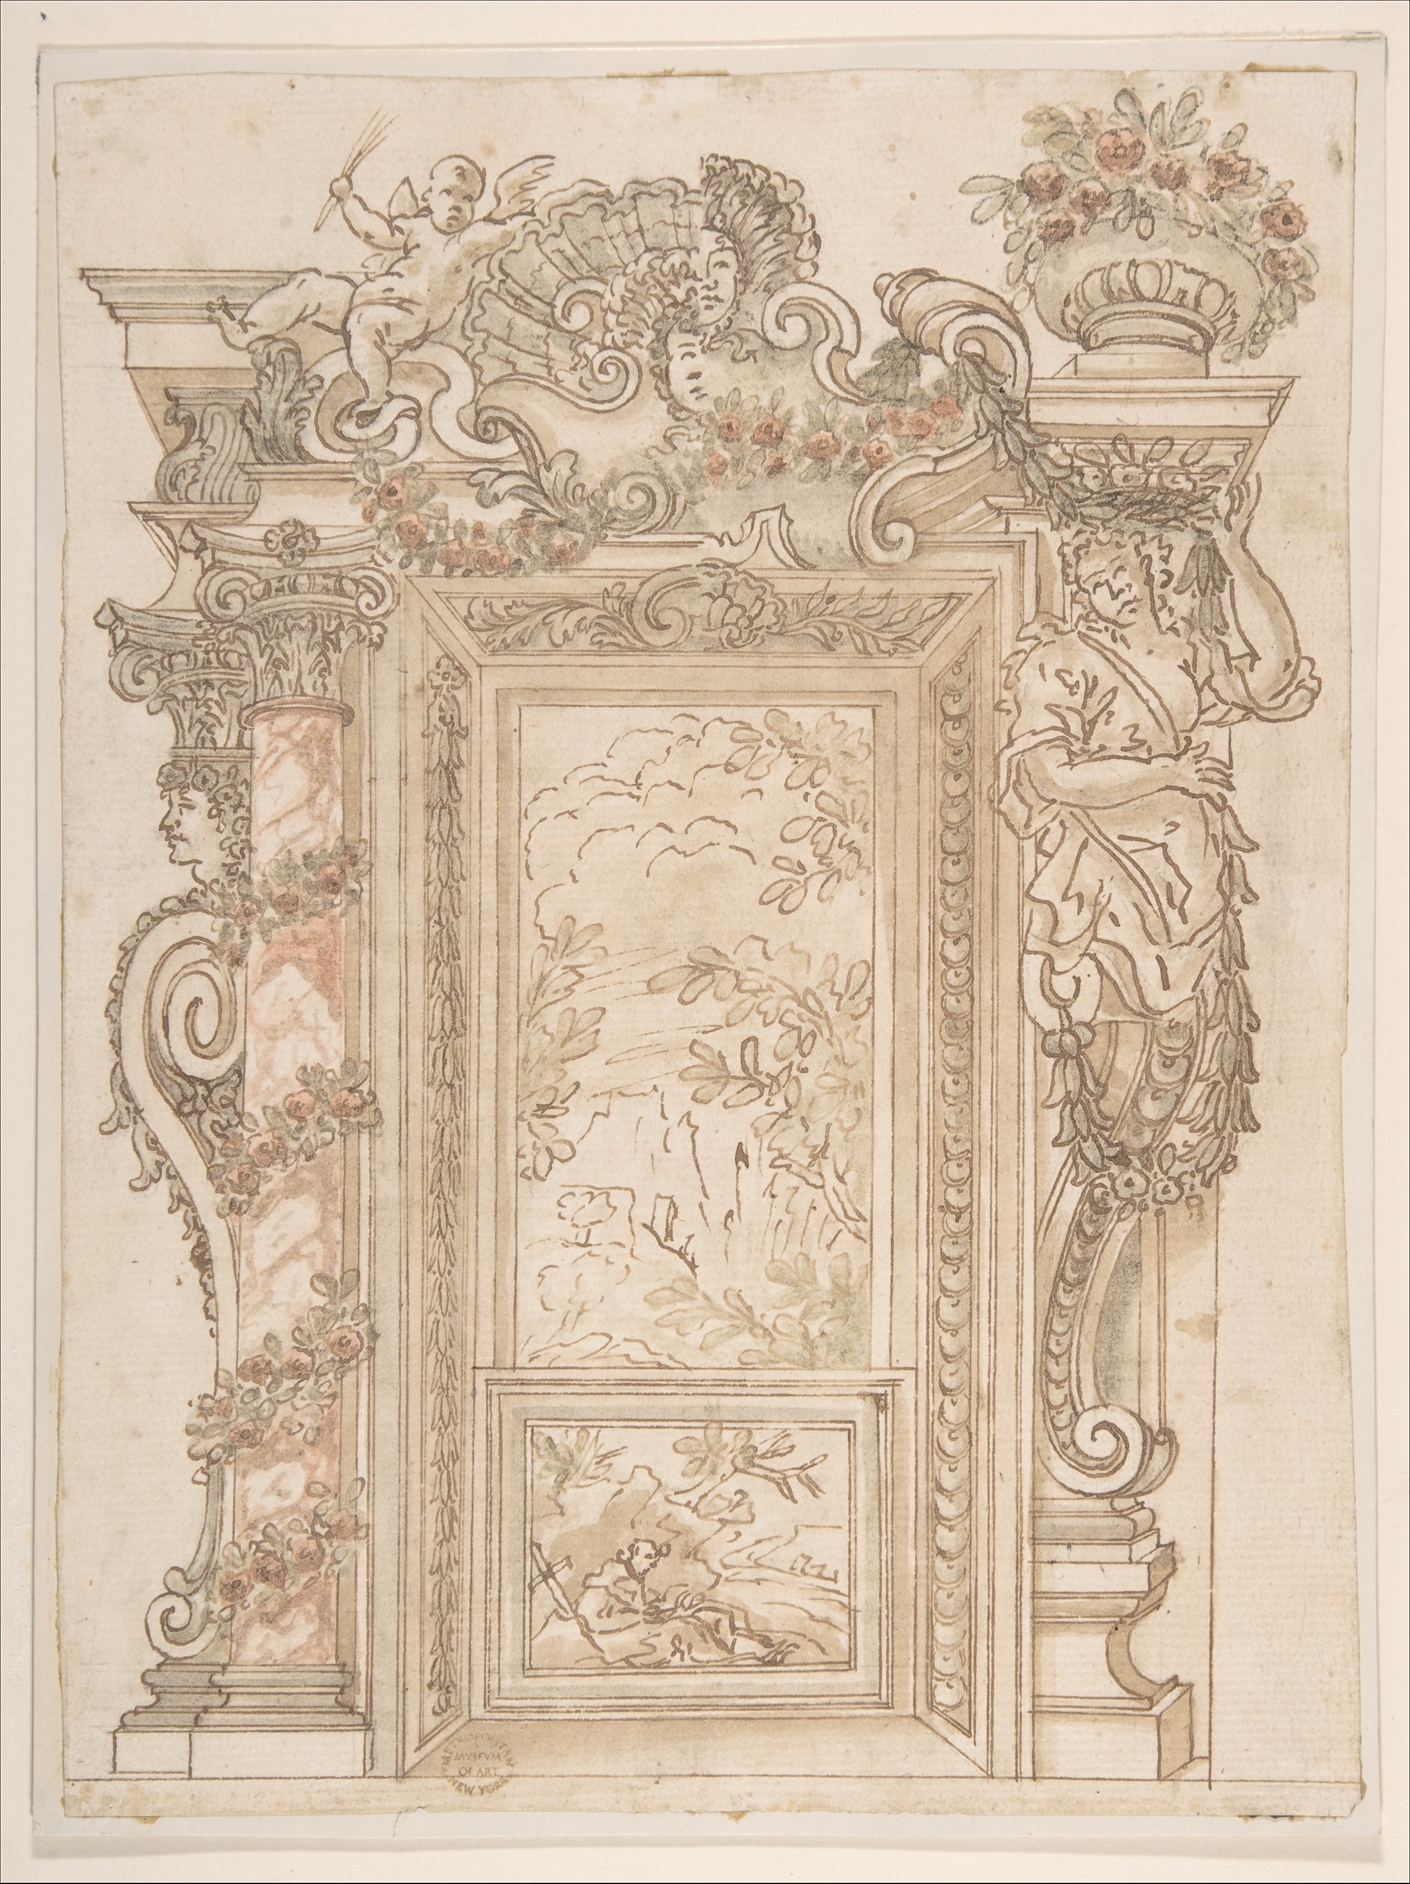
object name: drawing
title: Designs for a Niche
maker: anonymous, italian, roman-bolognese, 17th century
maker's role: artist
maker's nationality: italian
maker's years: 1600-1700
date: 1601-1700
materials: chalk, ink, paper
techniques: brush, pen, wash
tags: caryatids,ornament